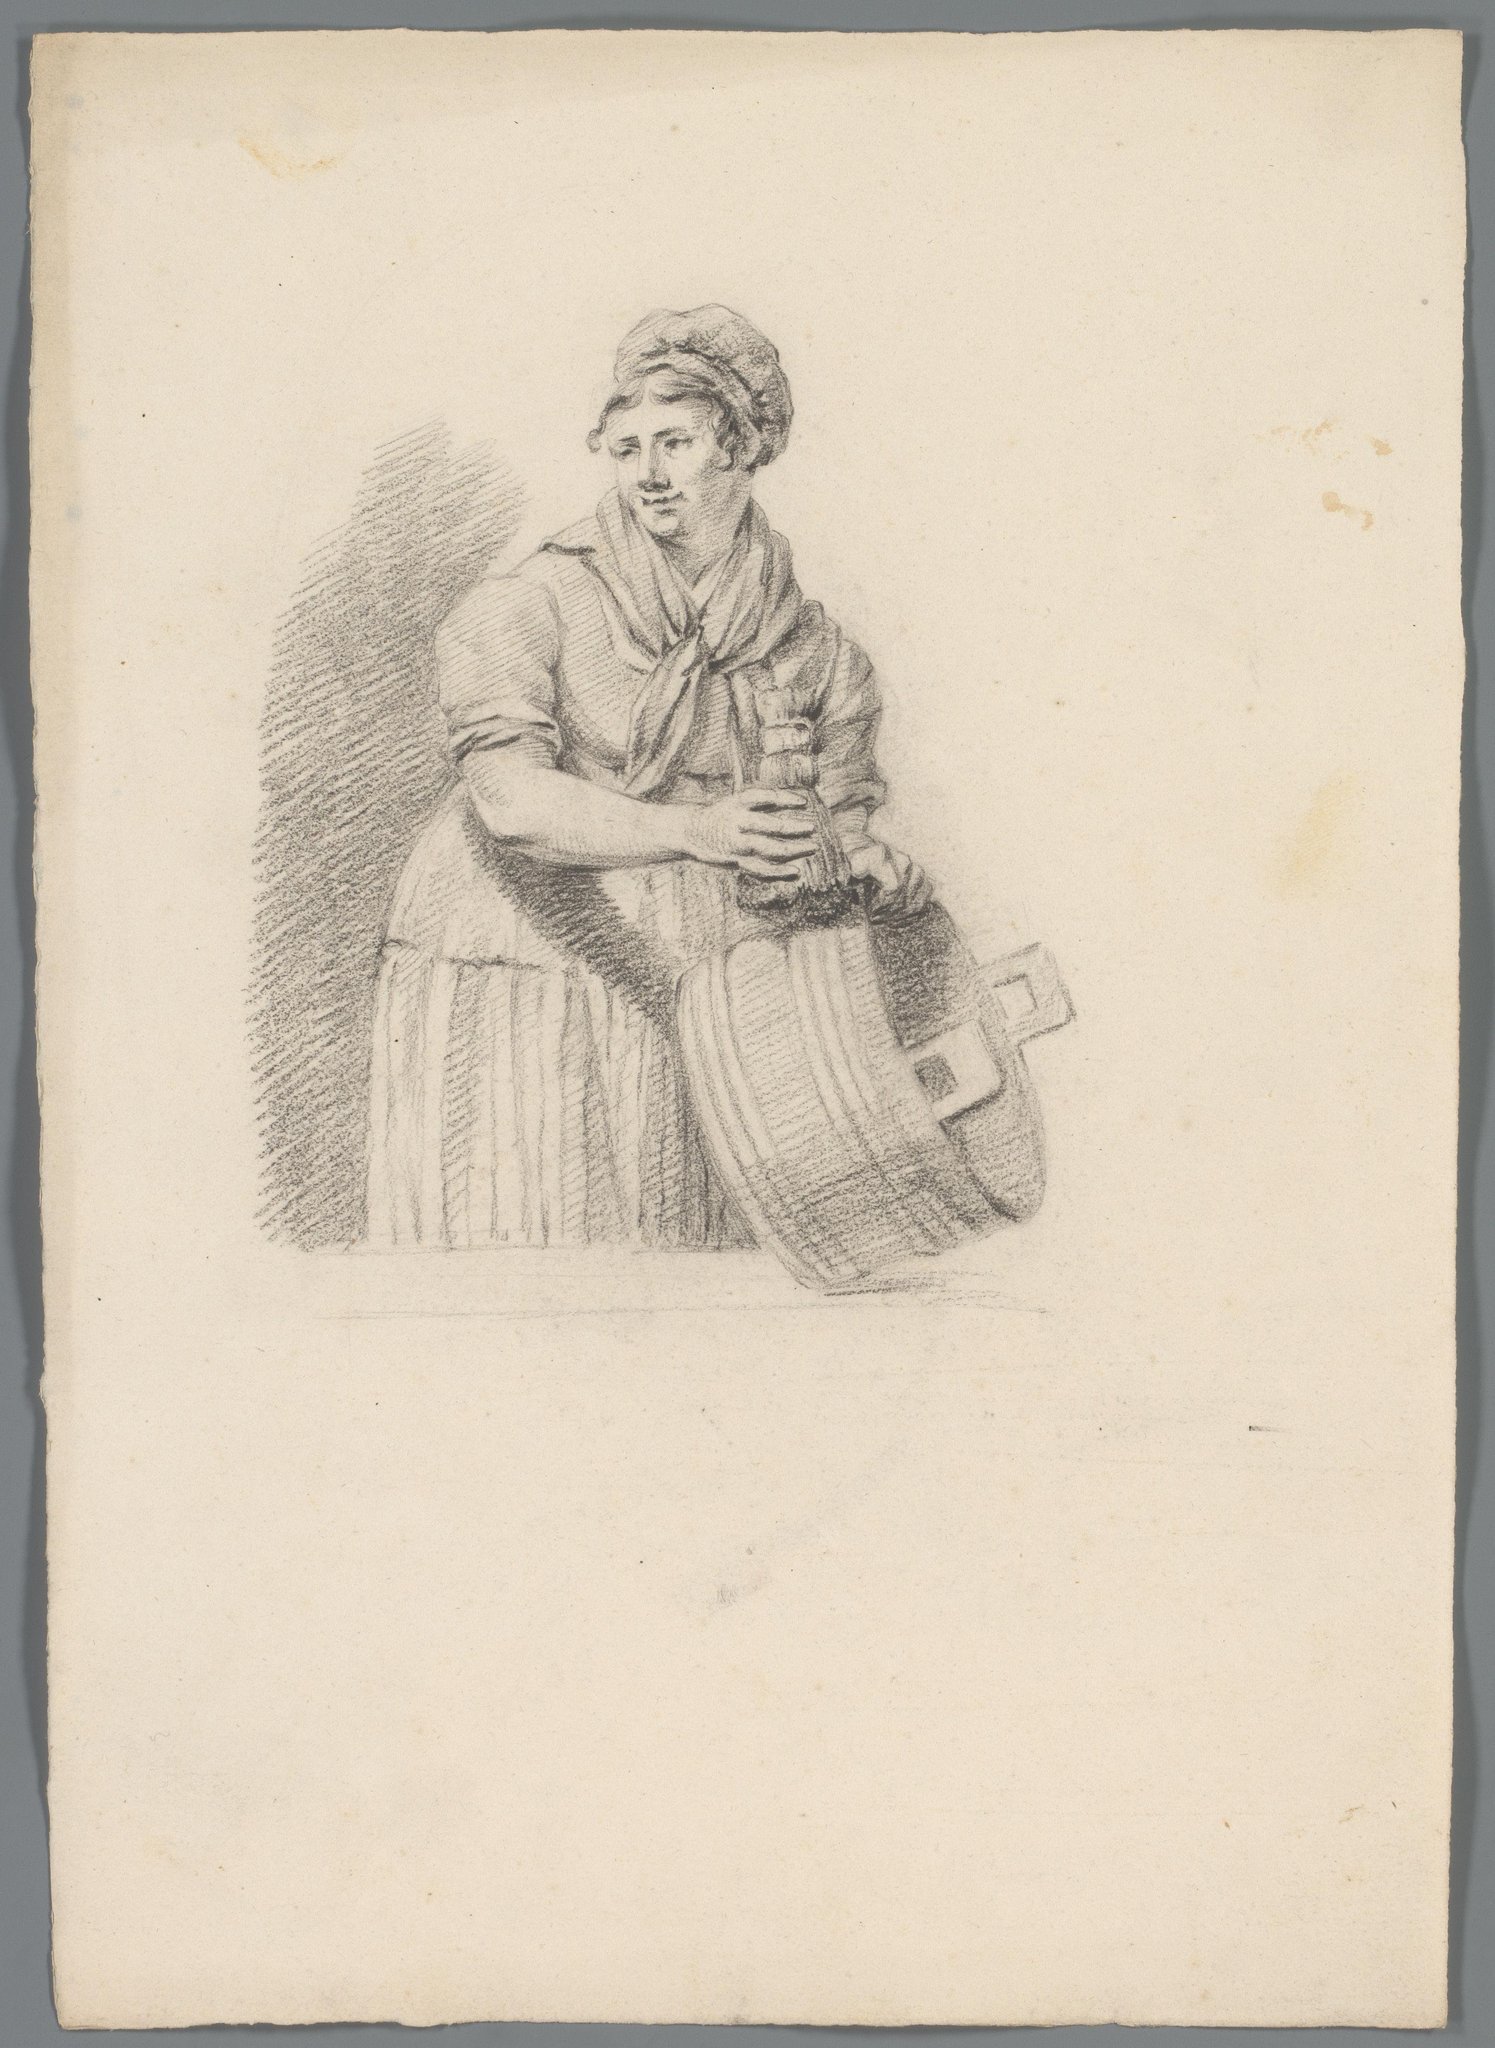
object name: drawing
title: Vrouw met wastobbe en borstel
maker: Anonymous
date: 1820-1830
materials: chalk, paper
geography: the hague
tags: wooden container: barrel, cask, bucket, adult woman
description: Tekeningen waarschijnlijk ontstaan bij het Haagse kunstgenootschap ‘Tot Nut der Tekenkunst’, waar twee keer per week tekenavonden werden georganiseerd met geklede modellen.